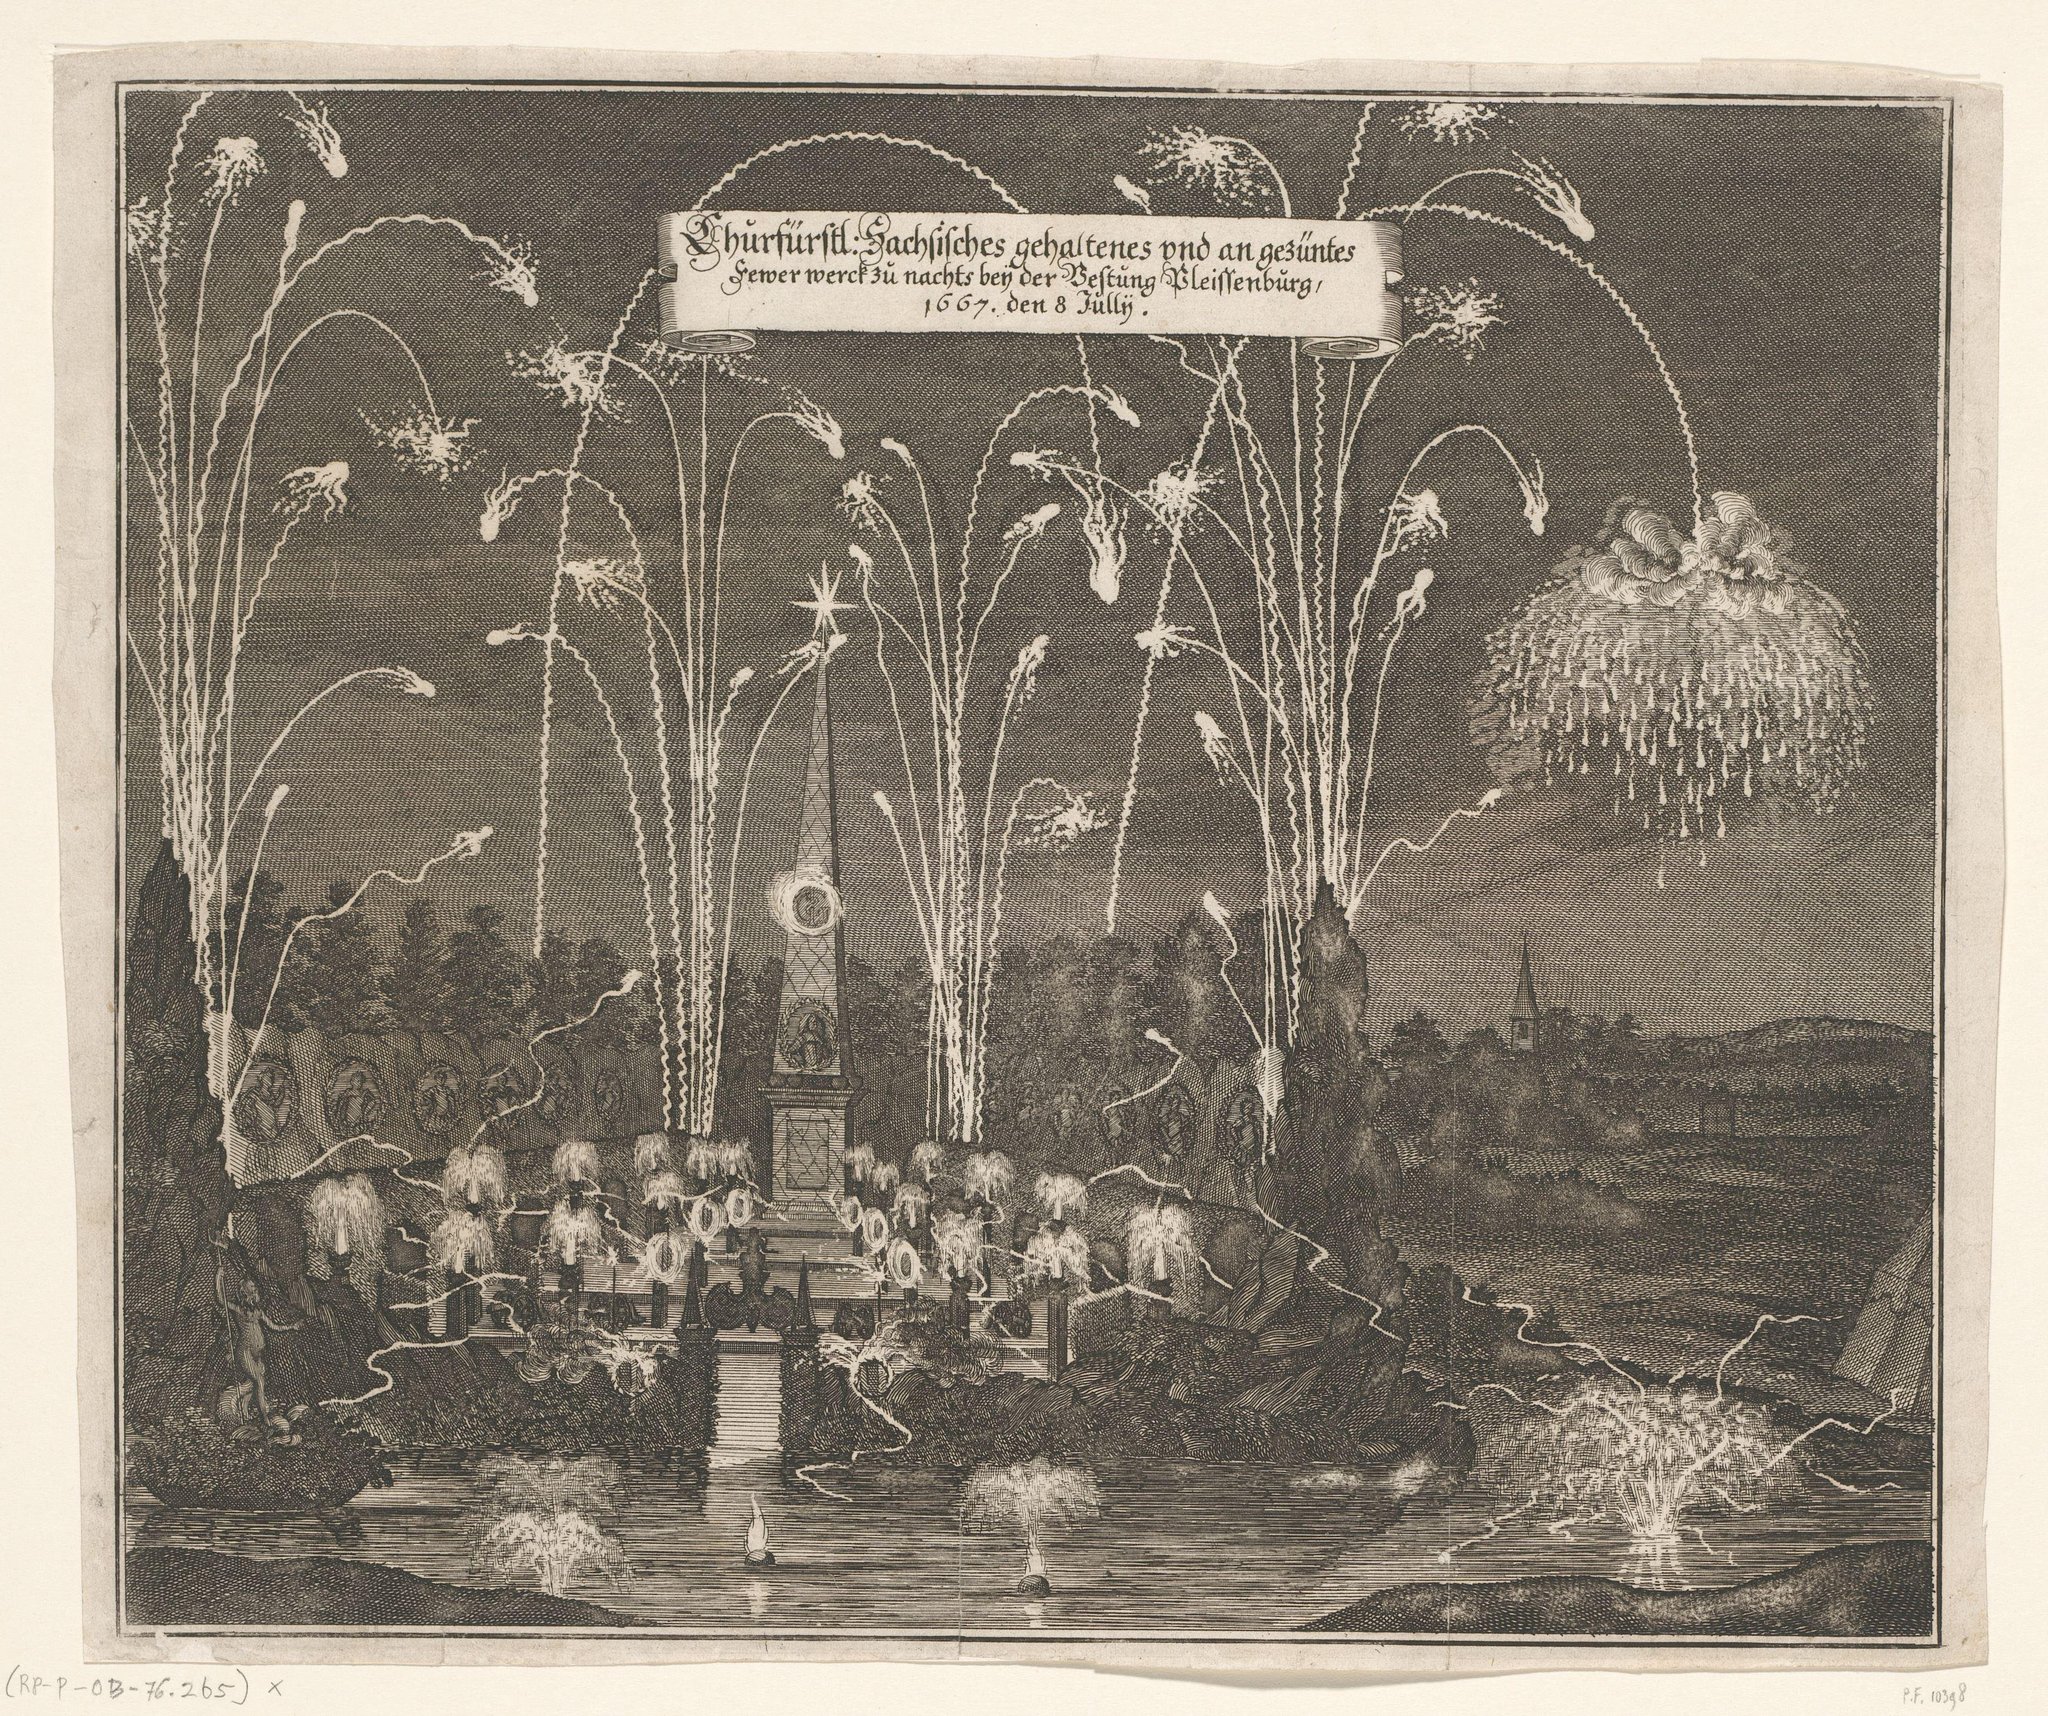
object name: print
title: Vuurwerk bij de Pleißenburg, 8 juli 1667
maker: Anonymous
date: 1667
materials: paper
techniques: etching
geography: germany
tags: bonfire, fire-works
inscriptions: collector's mark: Lugt 2228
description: Nachtelijk vuurwerk bij de Festung Pleißenburg in Saksen, 8 juli 1667.